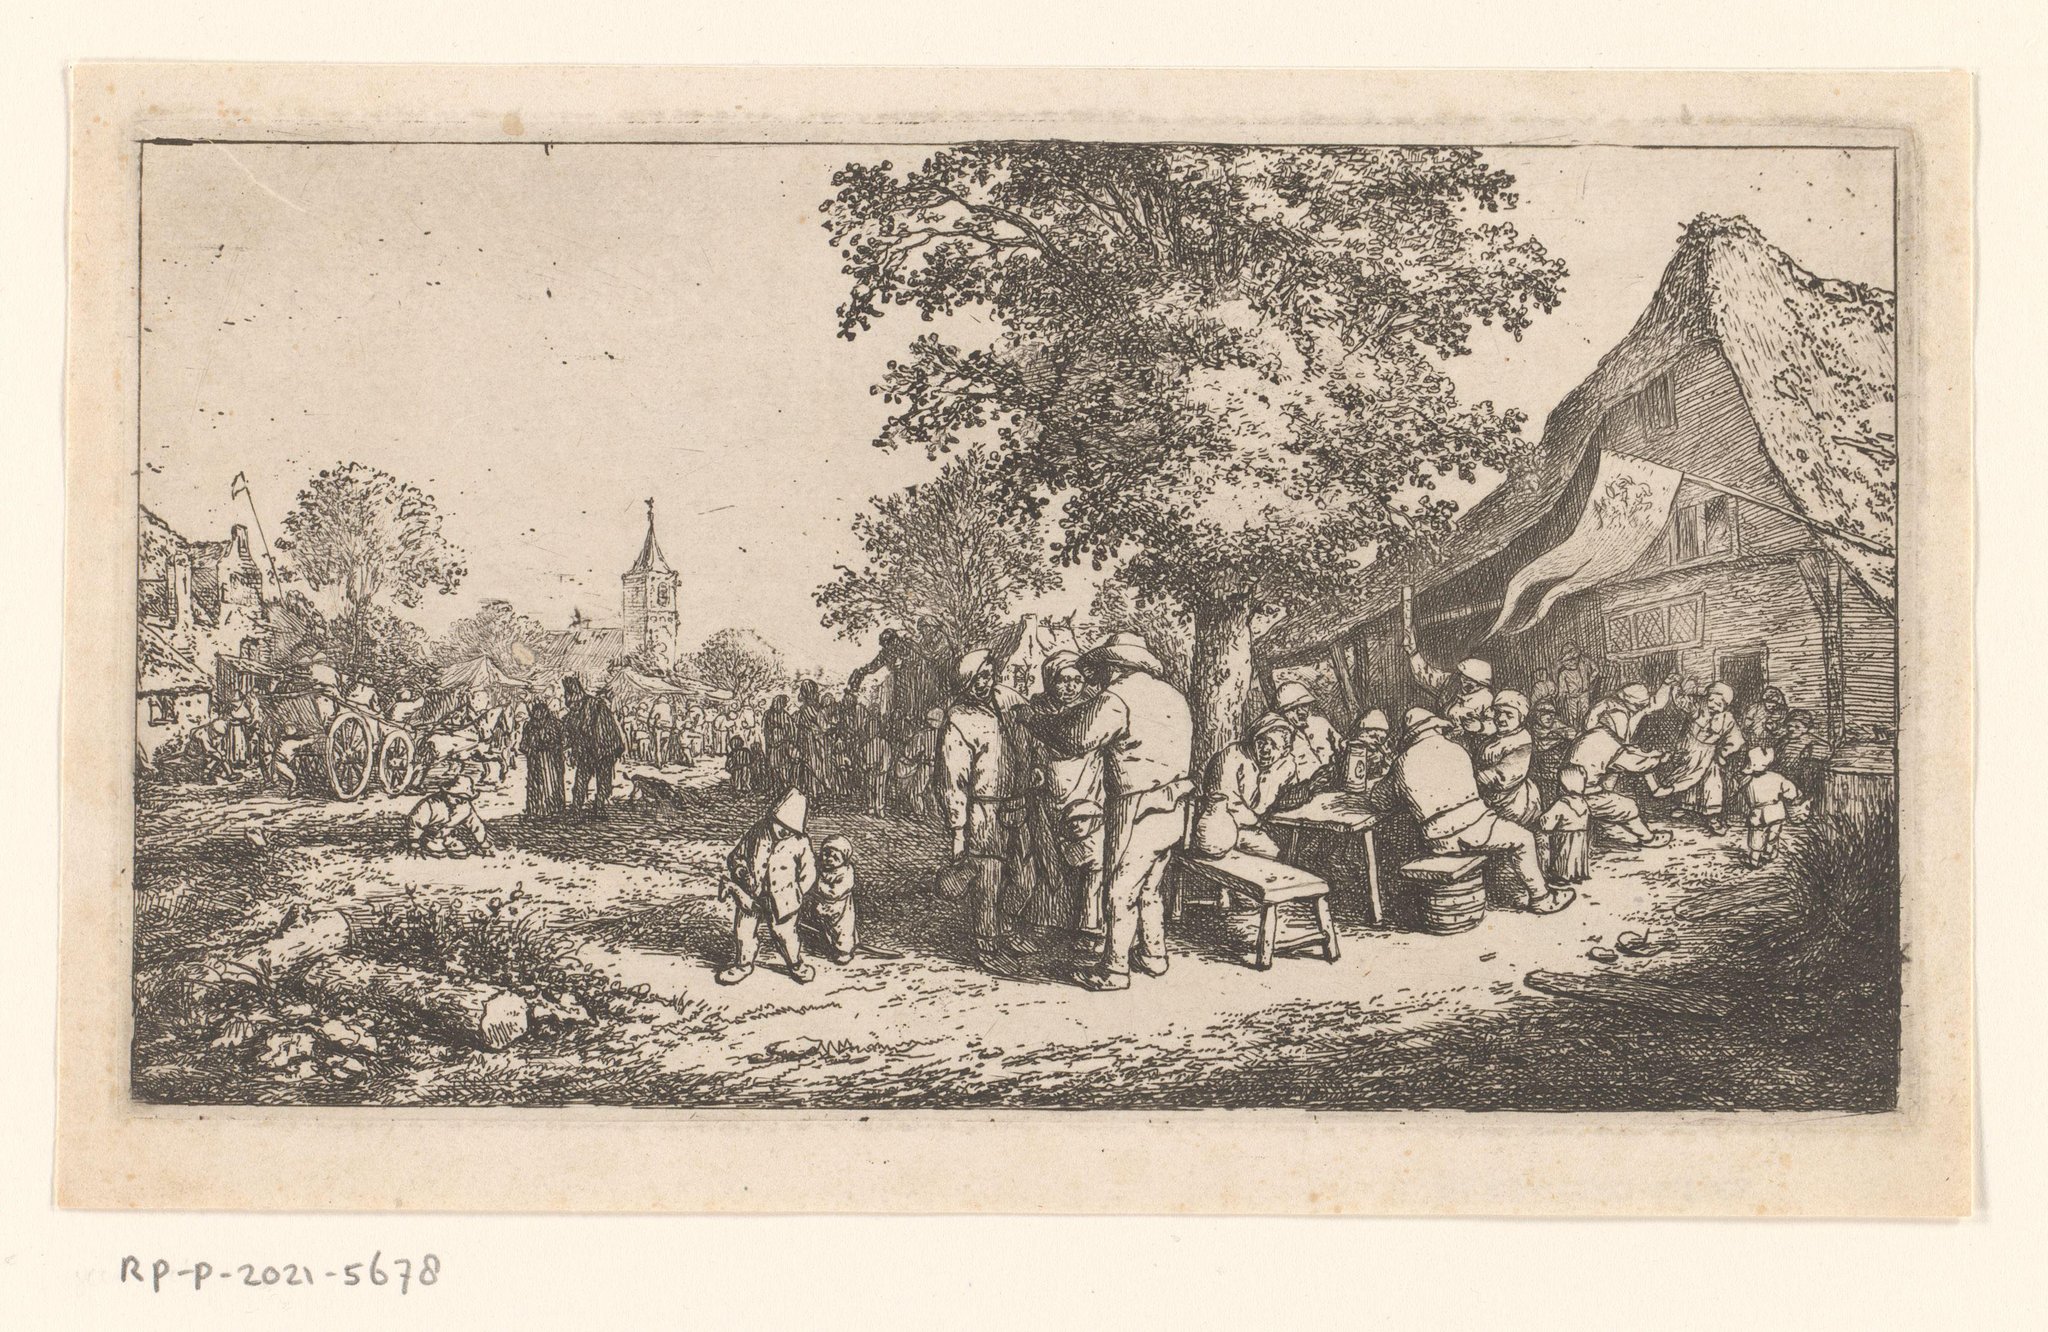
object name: print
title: Boerenkermis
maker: adriaen van ostade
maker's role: draughtsman, painter, print maker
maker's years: 1610-1685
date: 1652-1656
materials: paper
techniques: etching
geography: haarlem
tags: farmers, pleasure fair and circus